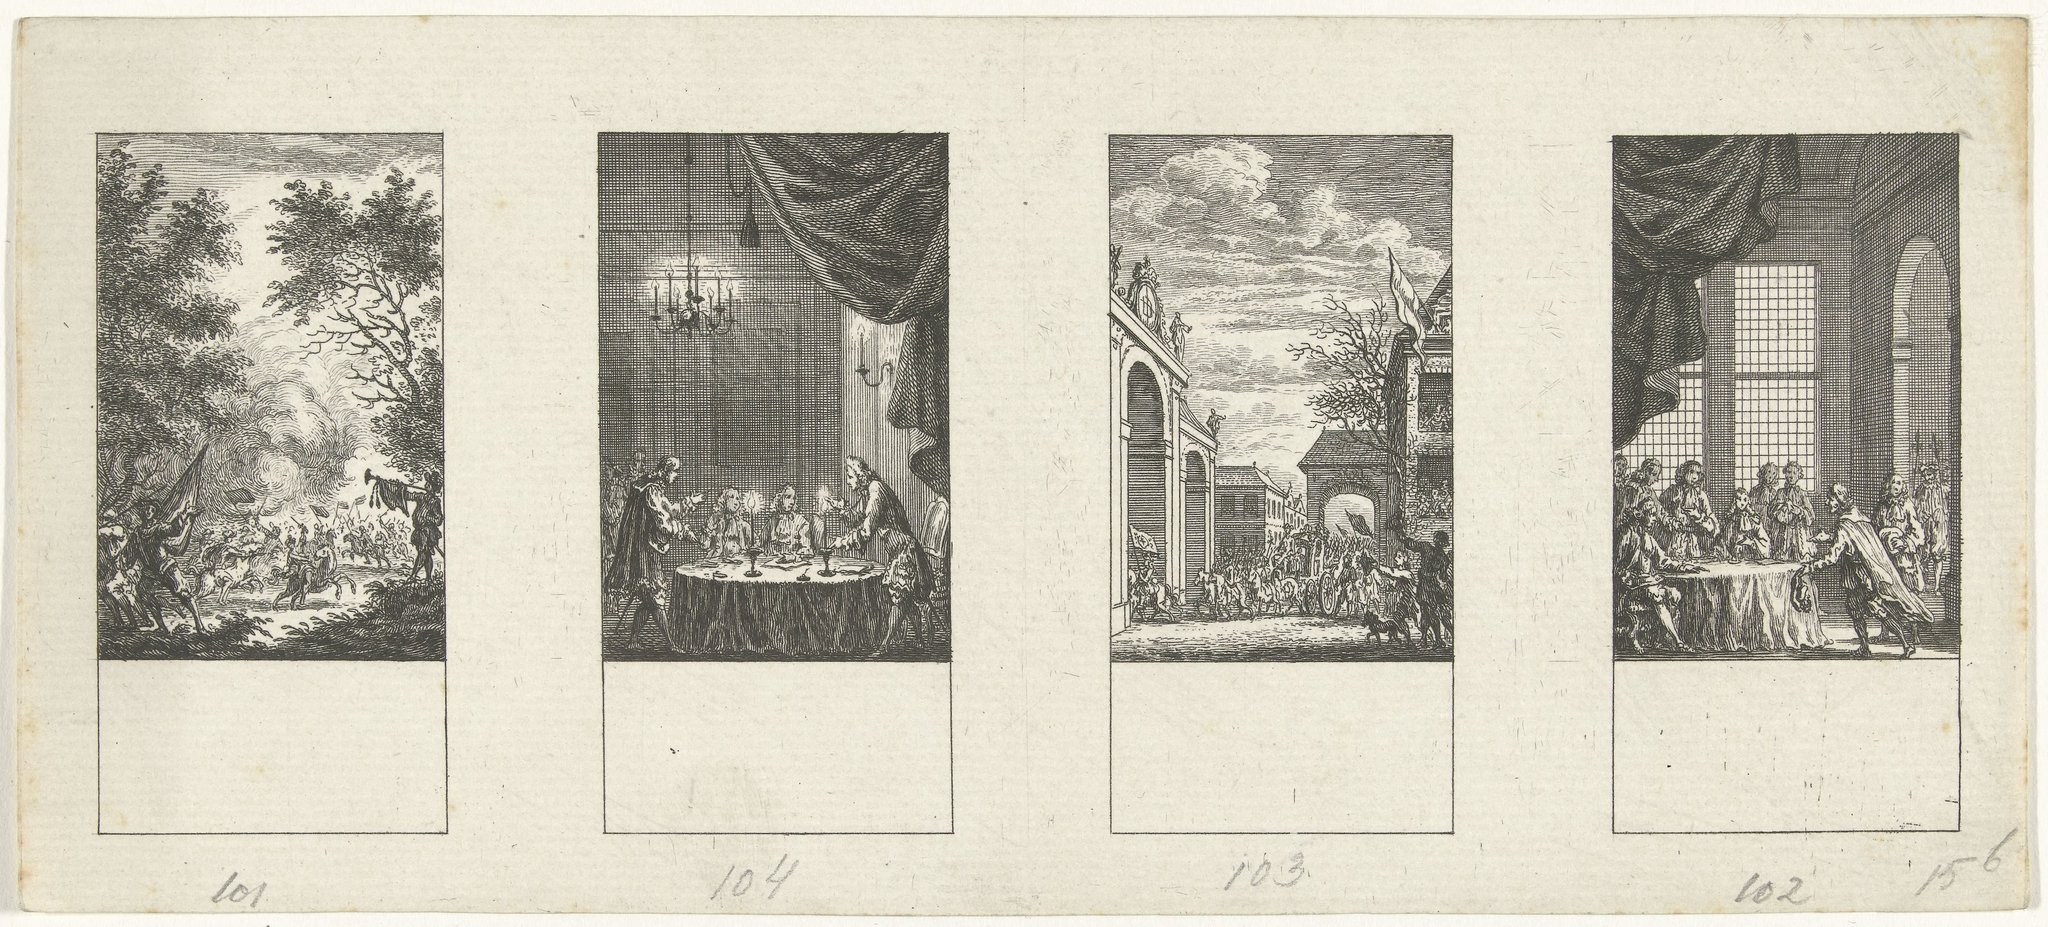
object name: print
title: Vier episodes uit de vaderlandse geschiedenis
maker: simon fokke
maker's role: draughtsman, print maker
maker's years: 1712-1784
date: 1722-1784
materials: paper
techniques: etching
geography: amsterdam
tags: flushing, michiel adriaenszoon de ruyter, london, maria ii stuart (koningin van engeland, schotland en ierland), historical events and situations, historical persons (portraits and scenes from the life)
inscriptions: collector's mark: Lugt 2228, number: ‘101, 104, 103, 102’